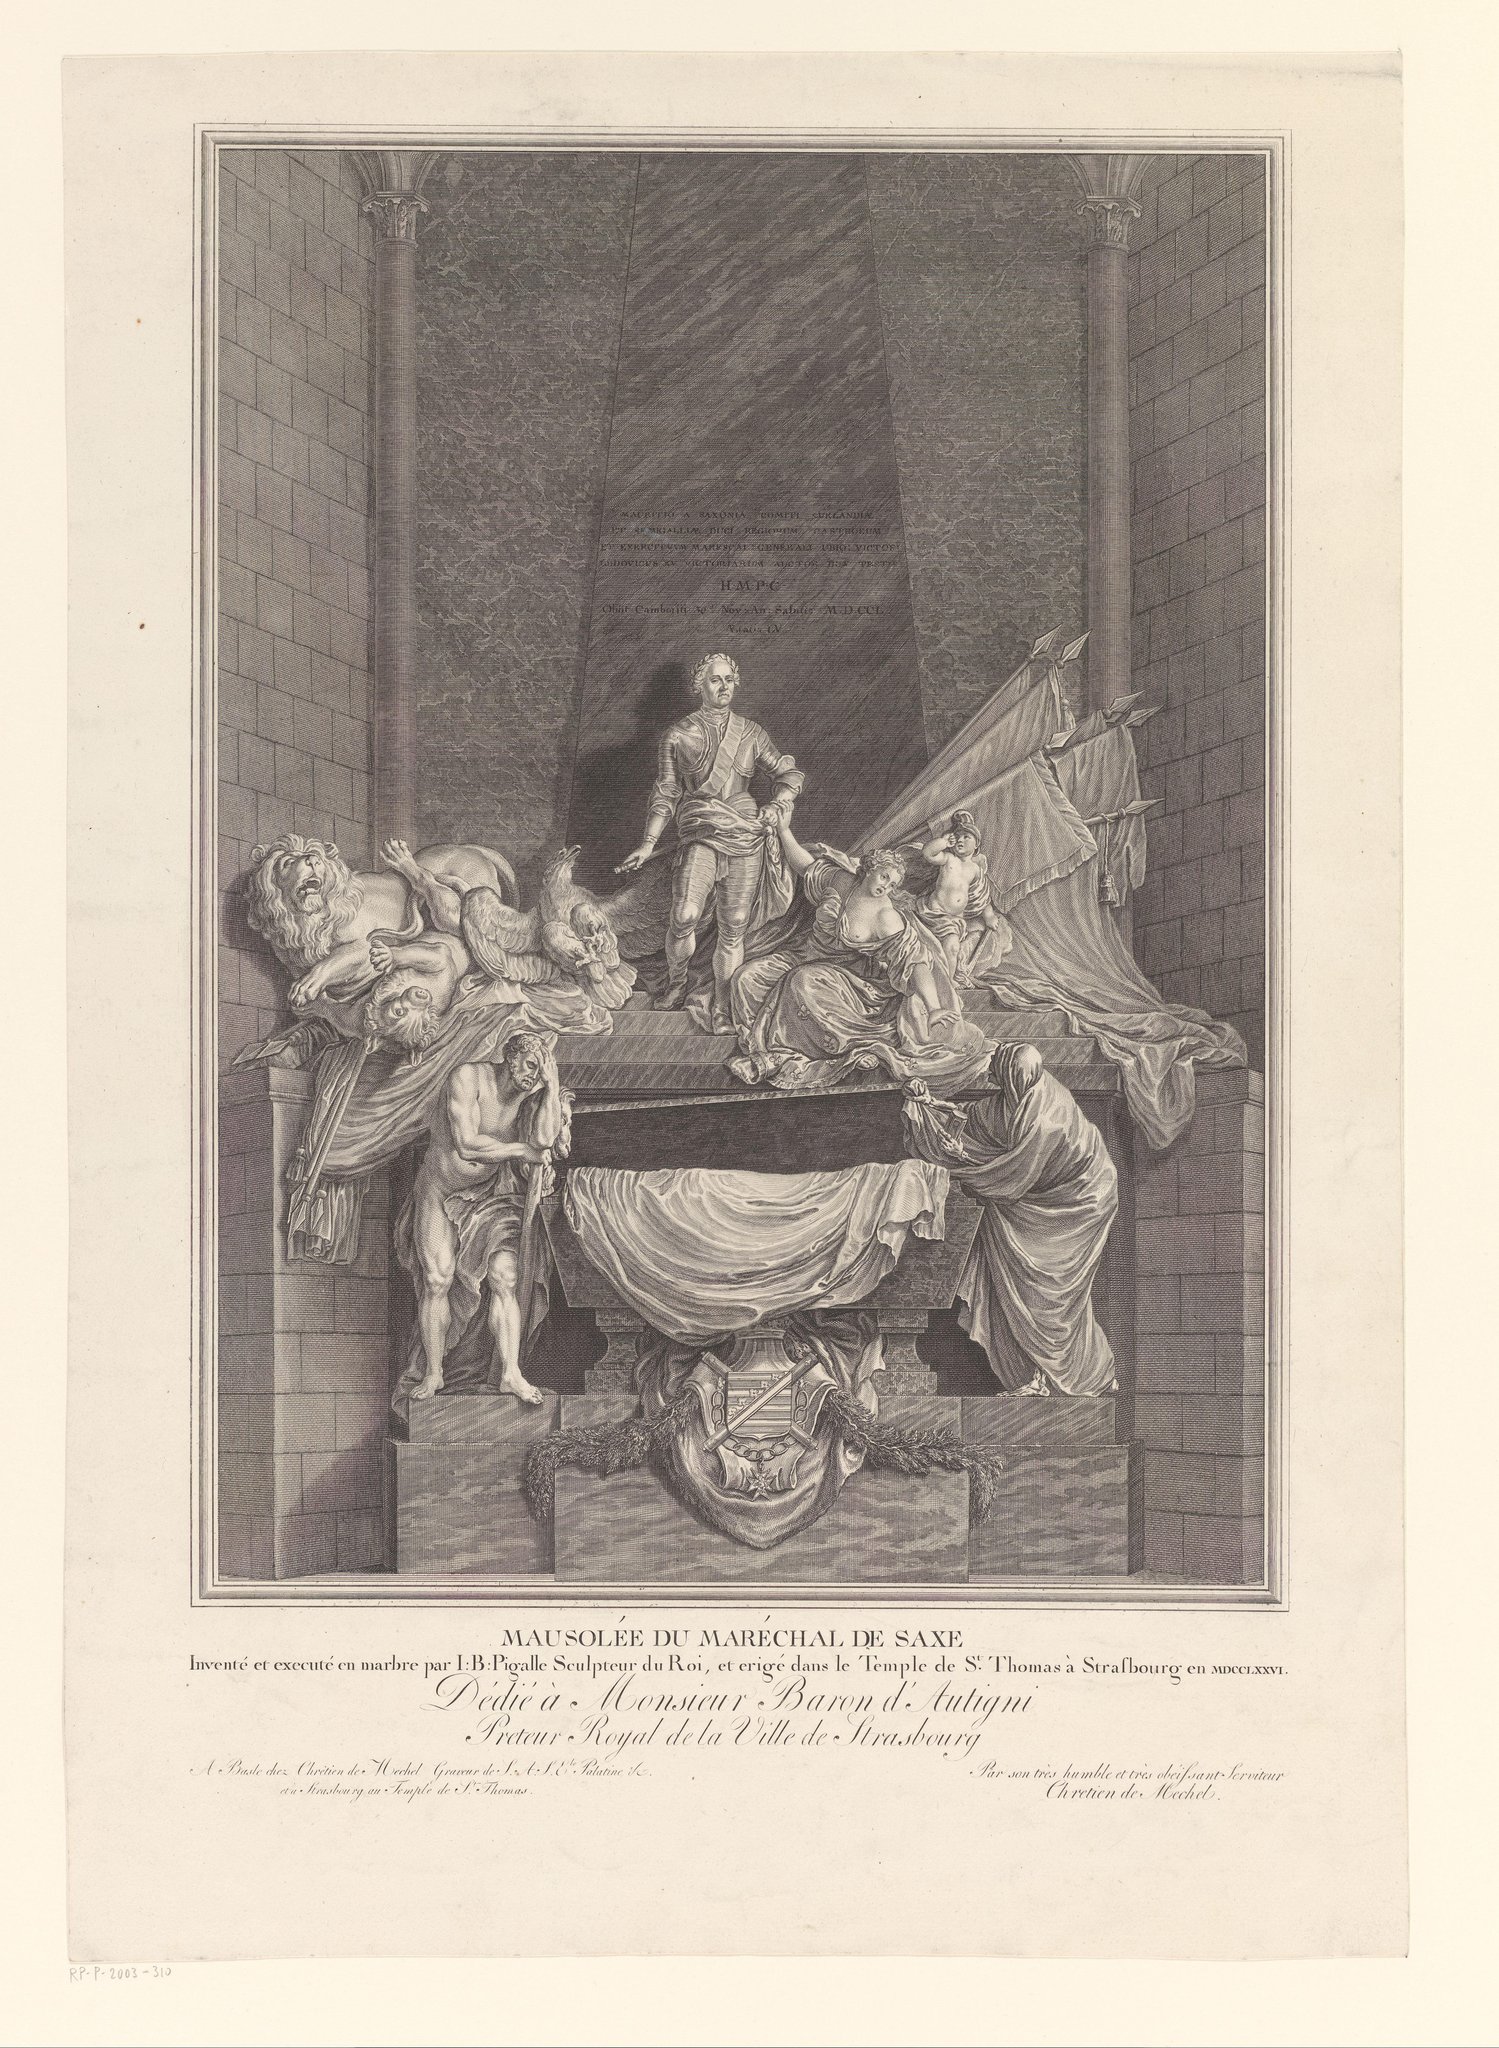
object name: print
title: Grafmonument voor Maurits van Saksen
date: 1776-1817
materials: paper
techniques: engraving, etching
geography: basel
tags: historical persons, monument, statue, grave-building, monumental tomb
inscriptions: collector's mark: Lugt 2228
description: Grafmonument uit 1776 van de beeldhouwer Jean Baptiste Pigalle voor maarschalk Maurits van Saksen in de Sint Thomaskerk te Straatsburg. Tekst in het Frans in de ondermarge en tekst in het Latijn op de vlakke obelisk achter het standbeeld van Maurits van Saksen.